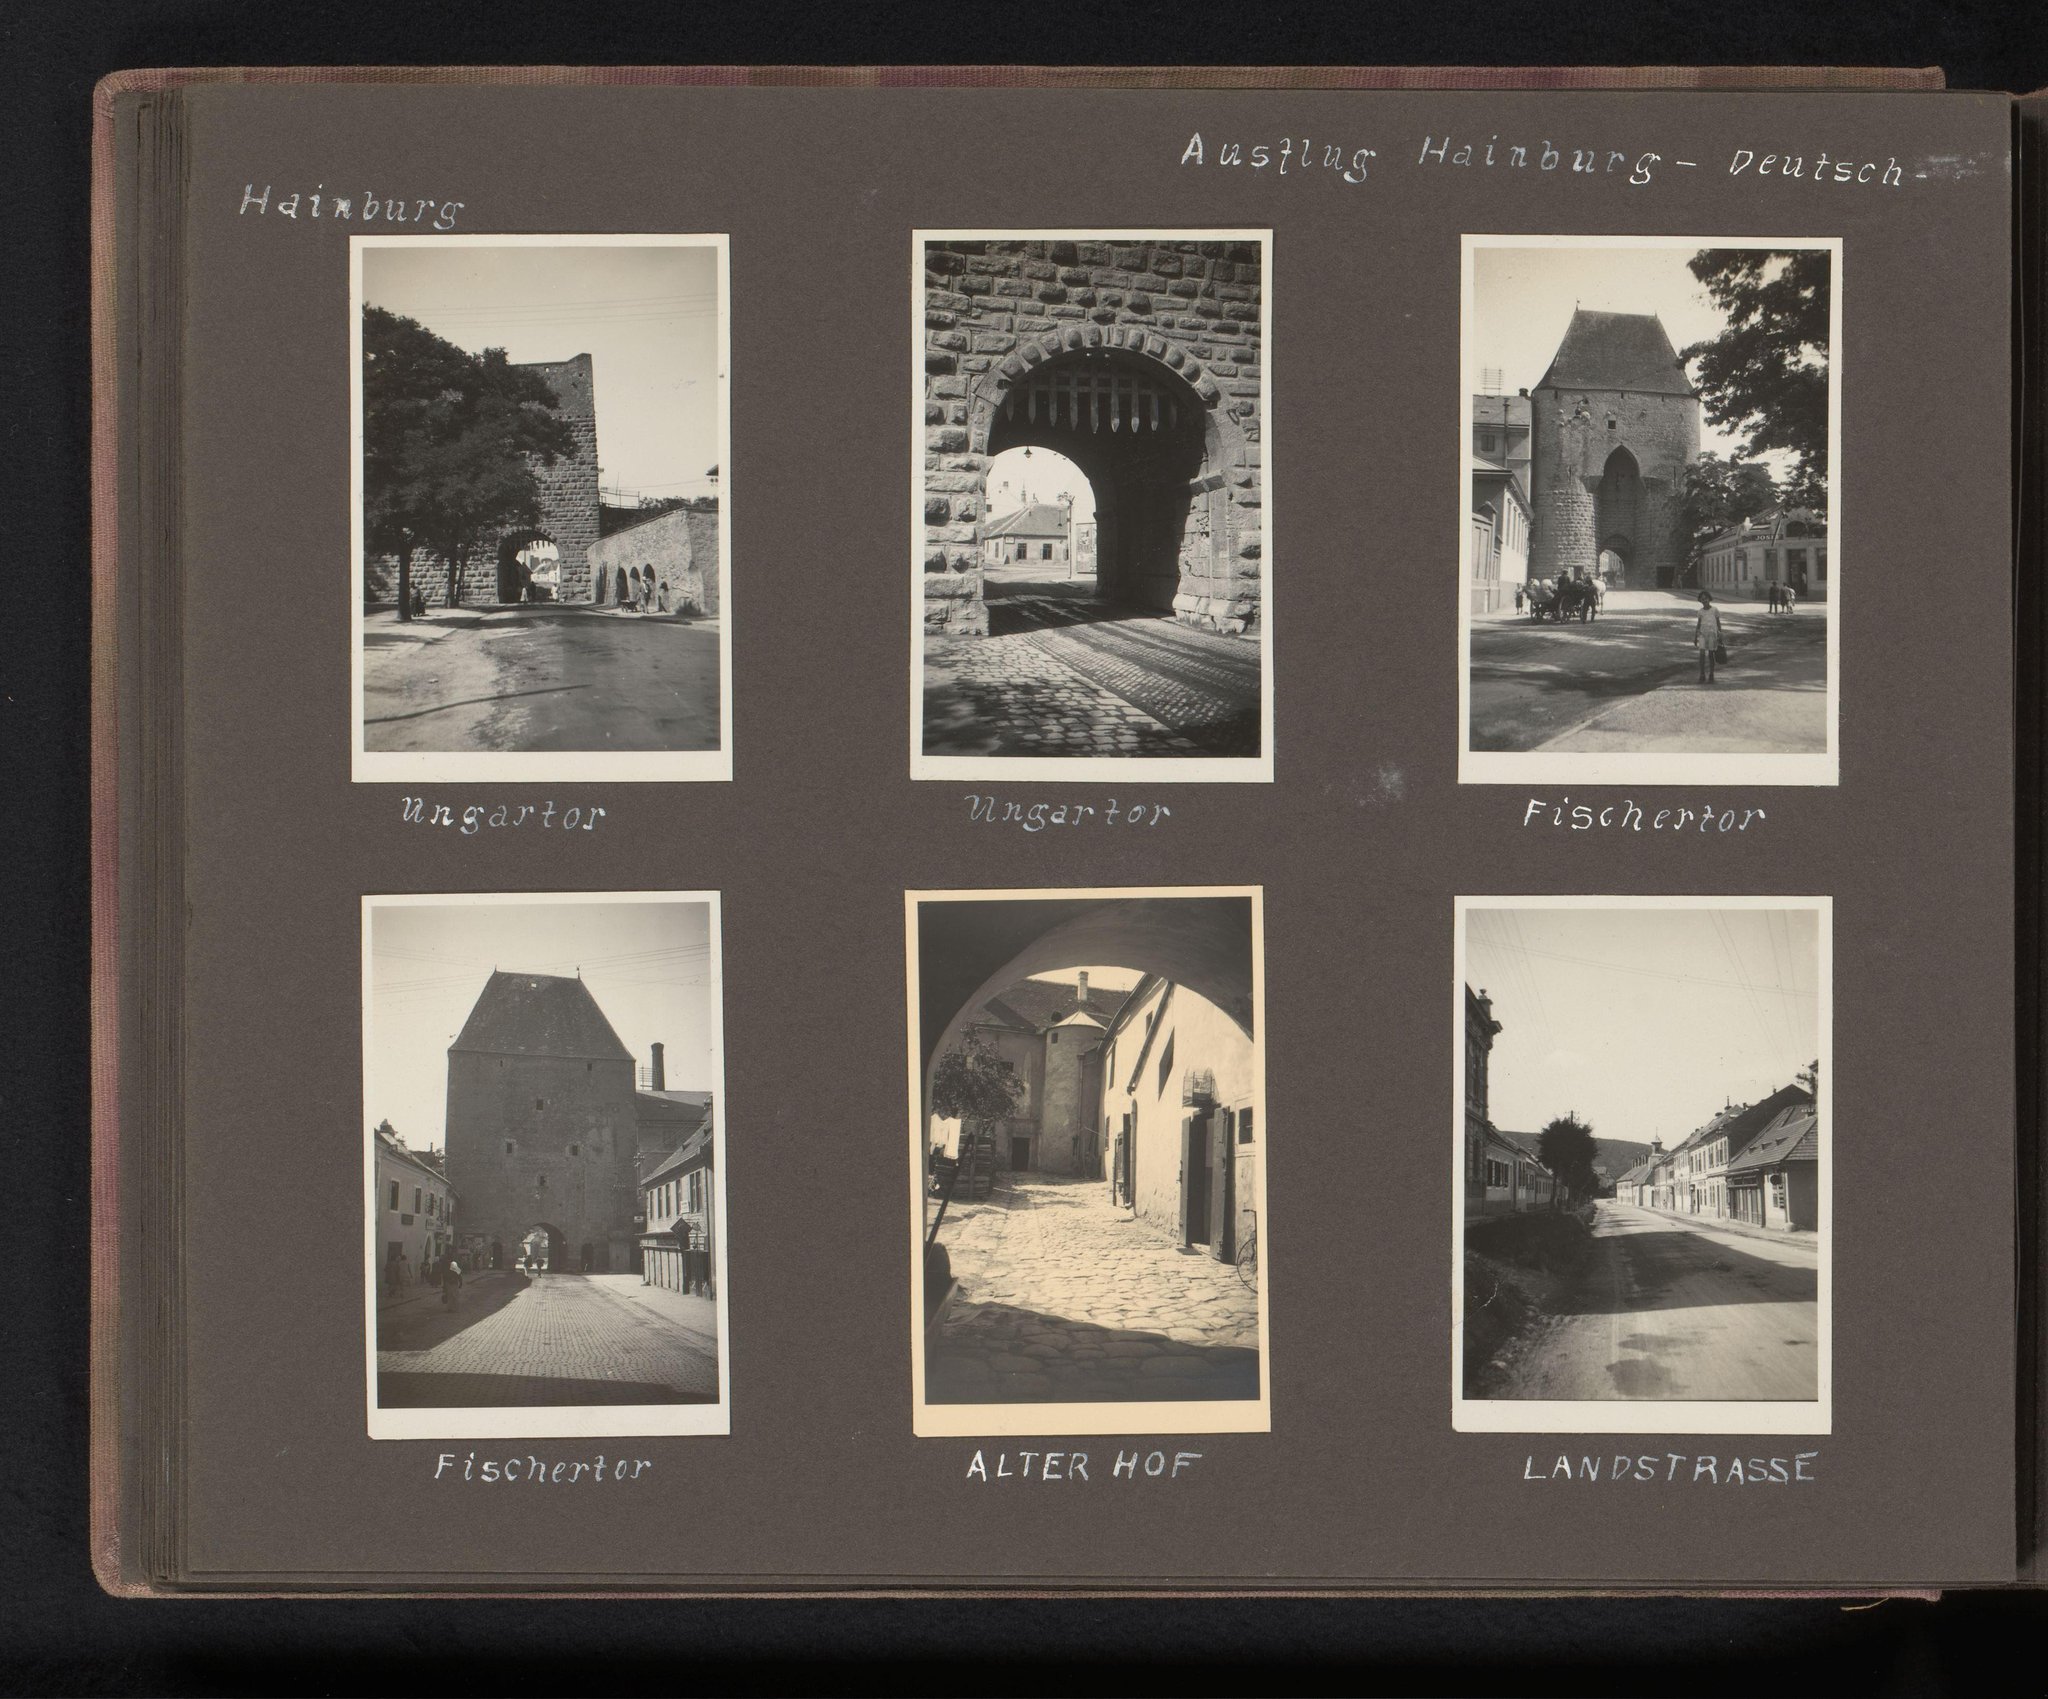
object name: photograph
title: Bezoek aan Hainburg an der Donau, Oostenrijk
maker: berti hoppe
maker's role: fotograaf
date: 1930-1931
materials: cardboard, photographic support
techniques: gelatin silver print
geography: hainburg an der donau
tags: courtyard, city-gate, street (+ city(-scape) with figures, staffage)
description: Vijf foto's van poorten en een foto van een straat in Hainburg an der Donau. In de onderschriften is vermeld dat het gaat om de Ungartor, de Fischertor, een oud hofje en de Landstrasse. Deze foto's maken deel uit van een album.